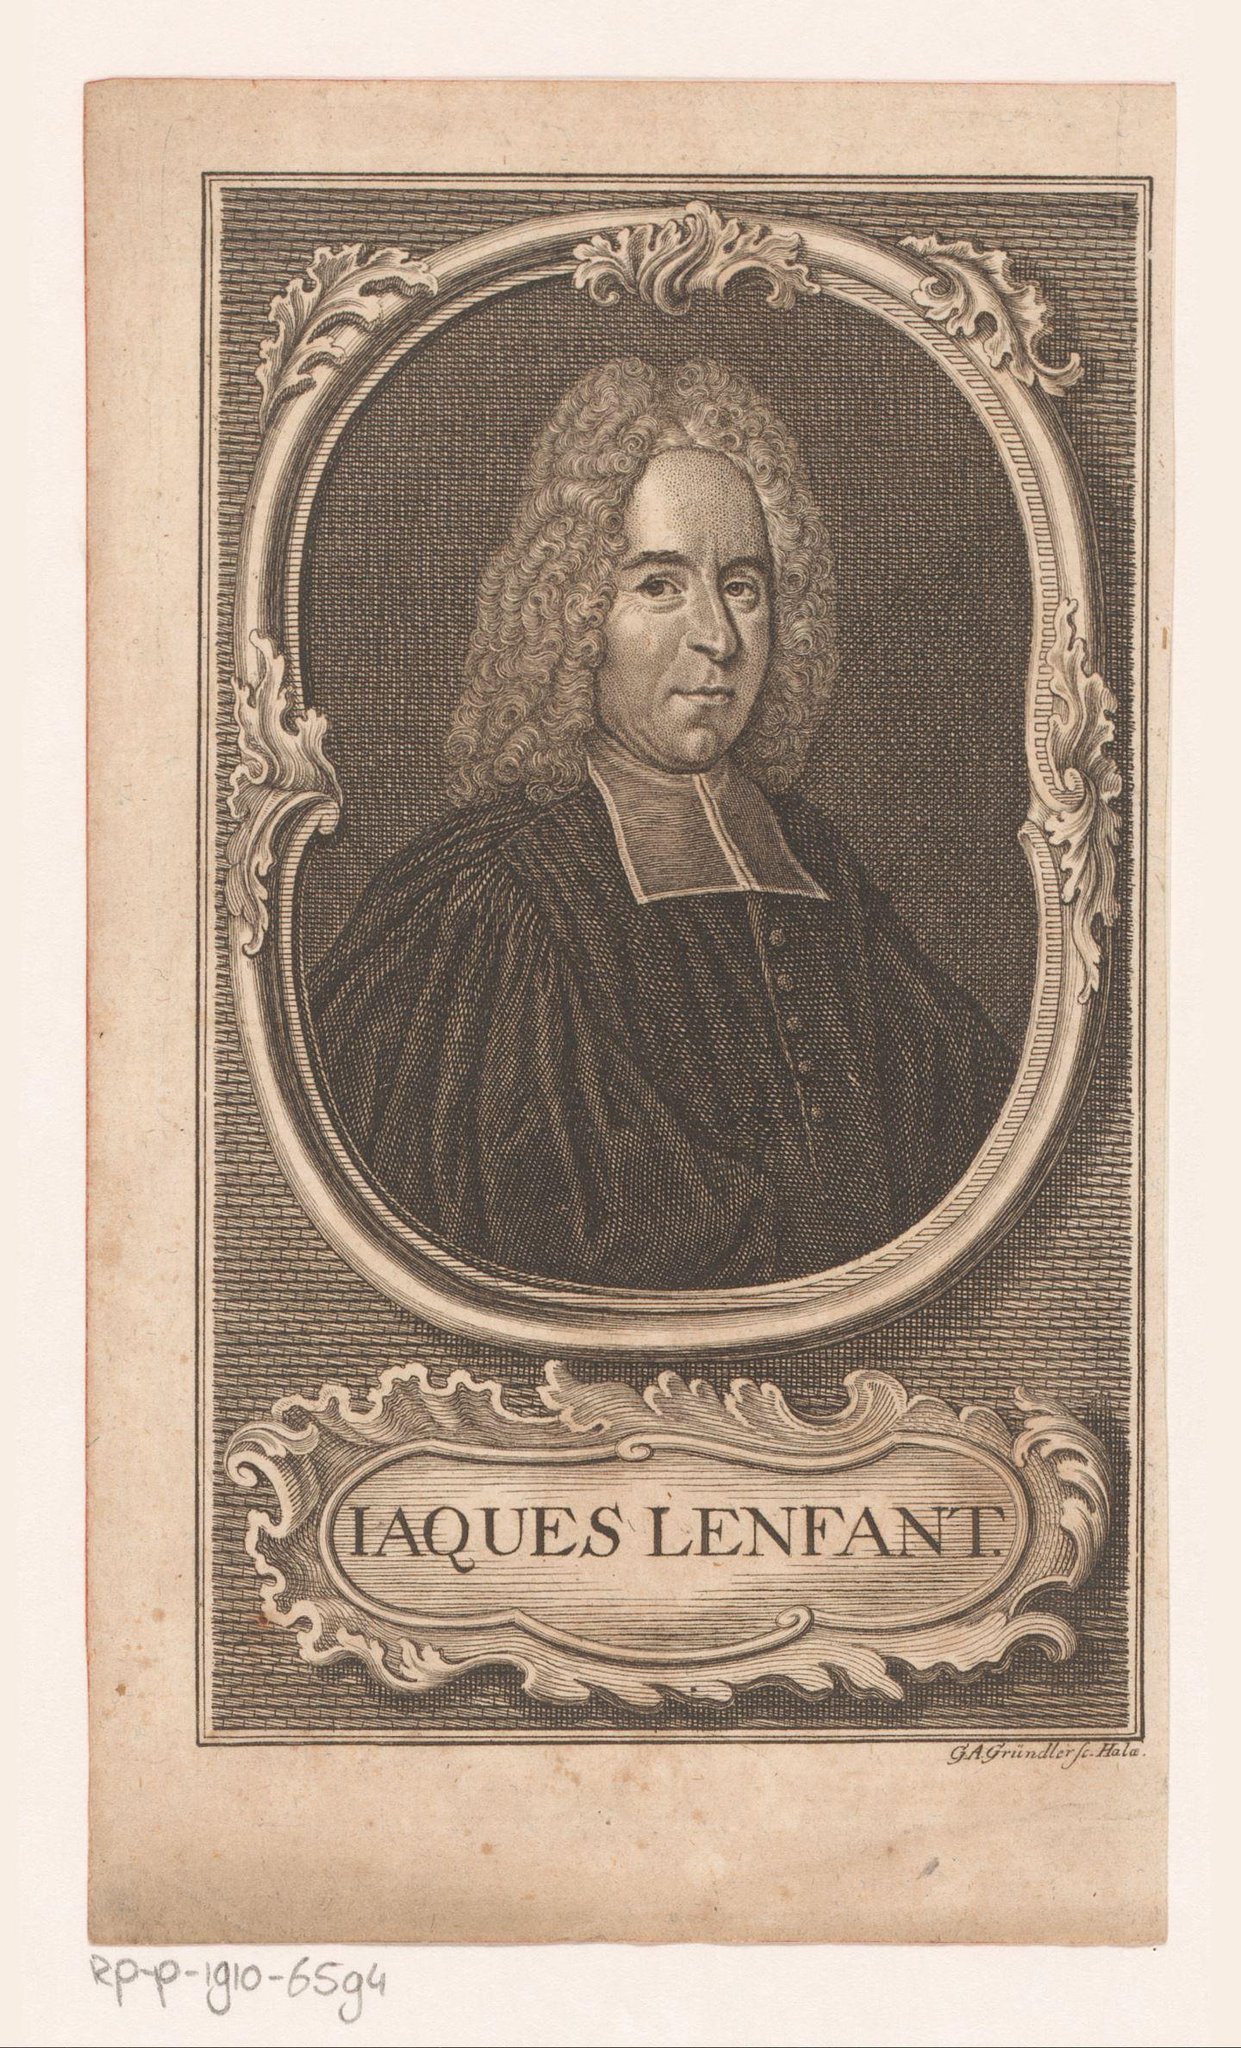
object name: print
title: Portret van Jacques Lenfant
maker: gottfried august gründler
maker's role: painter, print maker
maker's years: 1710-1775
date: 1720-1775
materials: paper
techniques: engraving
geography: halle an der saale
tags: berlin, historical persons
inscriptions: collector's mark: Lugt 2228